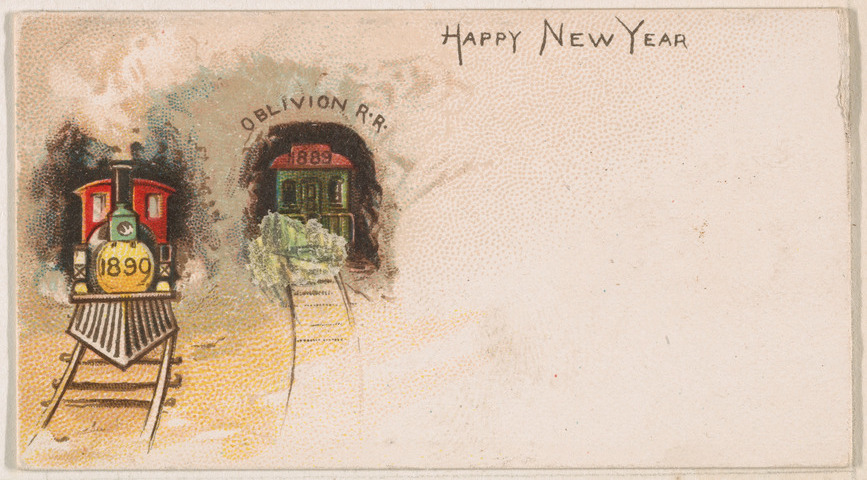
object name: print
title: Happy New Year, from the New Years 1890 series (N227) issued by Kinney Bros.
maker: kinney brothers tobacco company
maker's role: publisher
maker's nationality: american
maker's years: 1869-2011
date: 1889-1890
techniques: color lithograph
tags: railways,trains